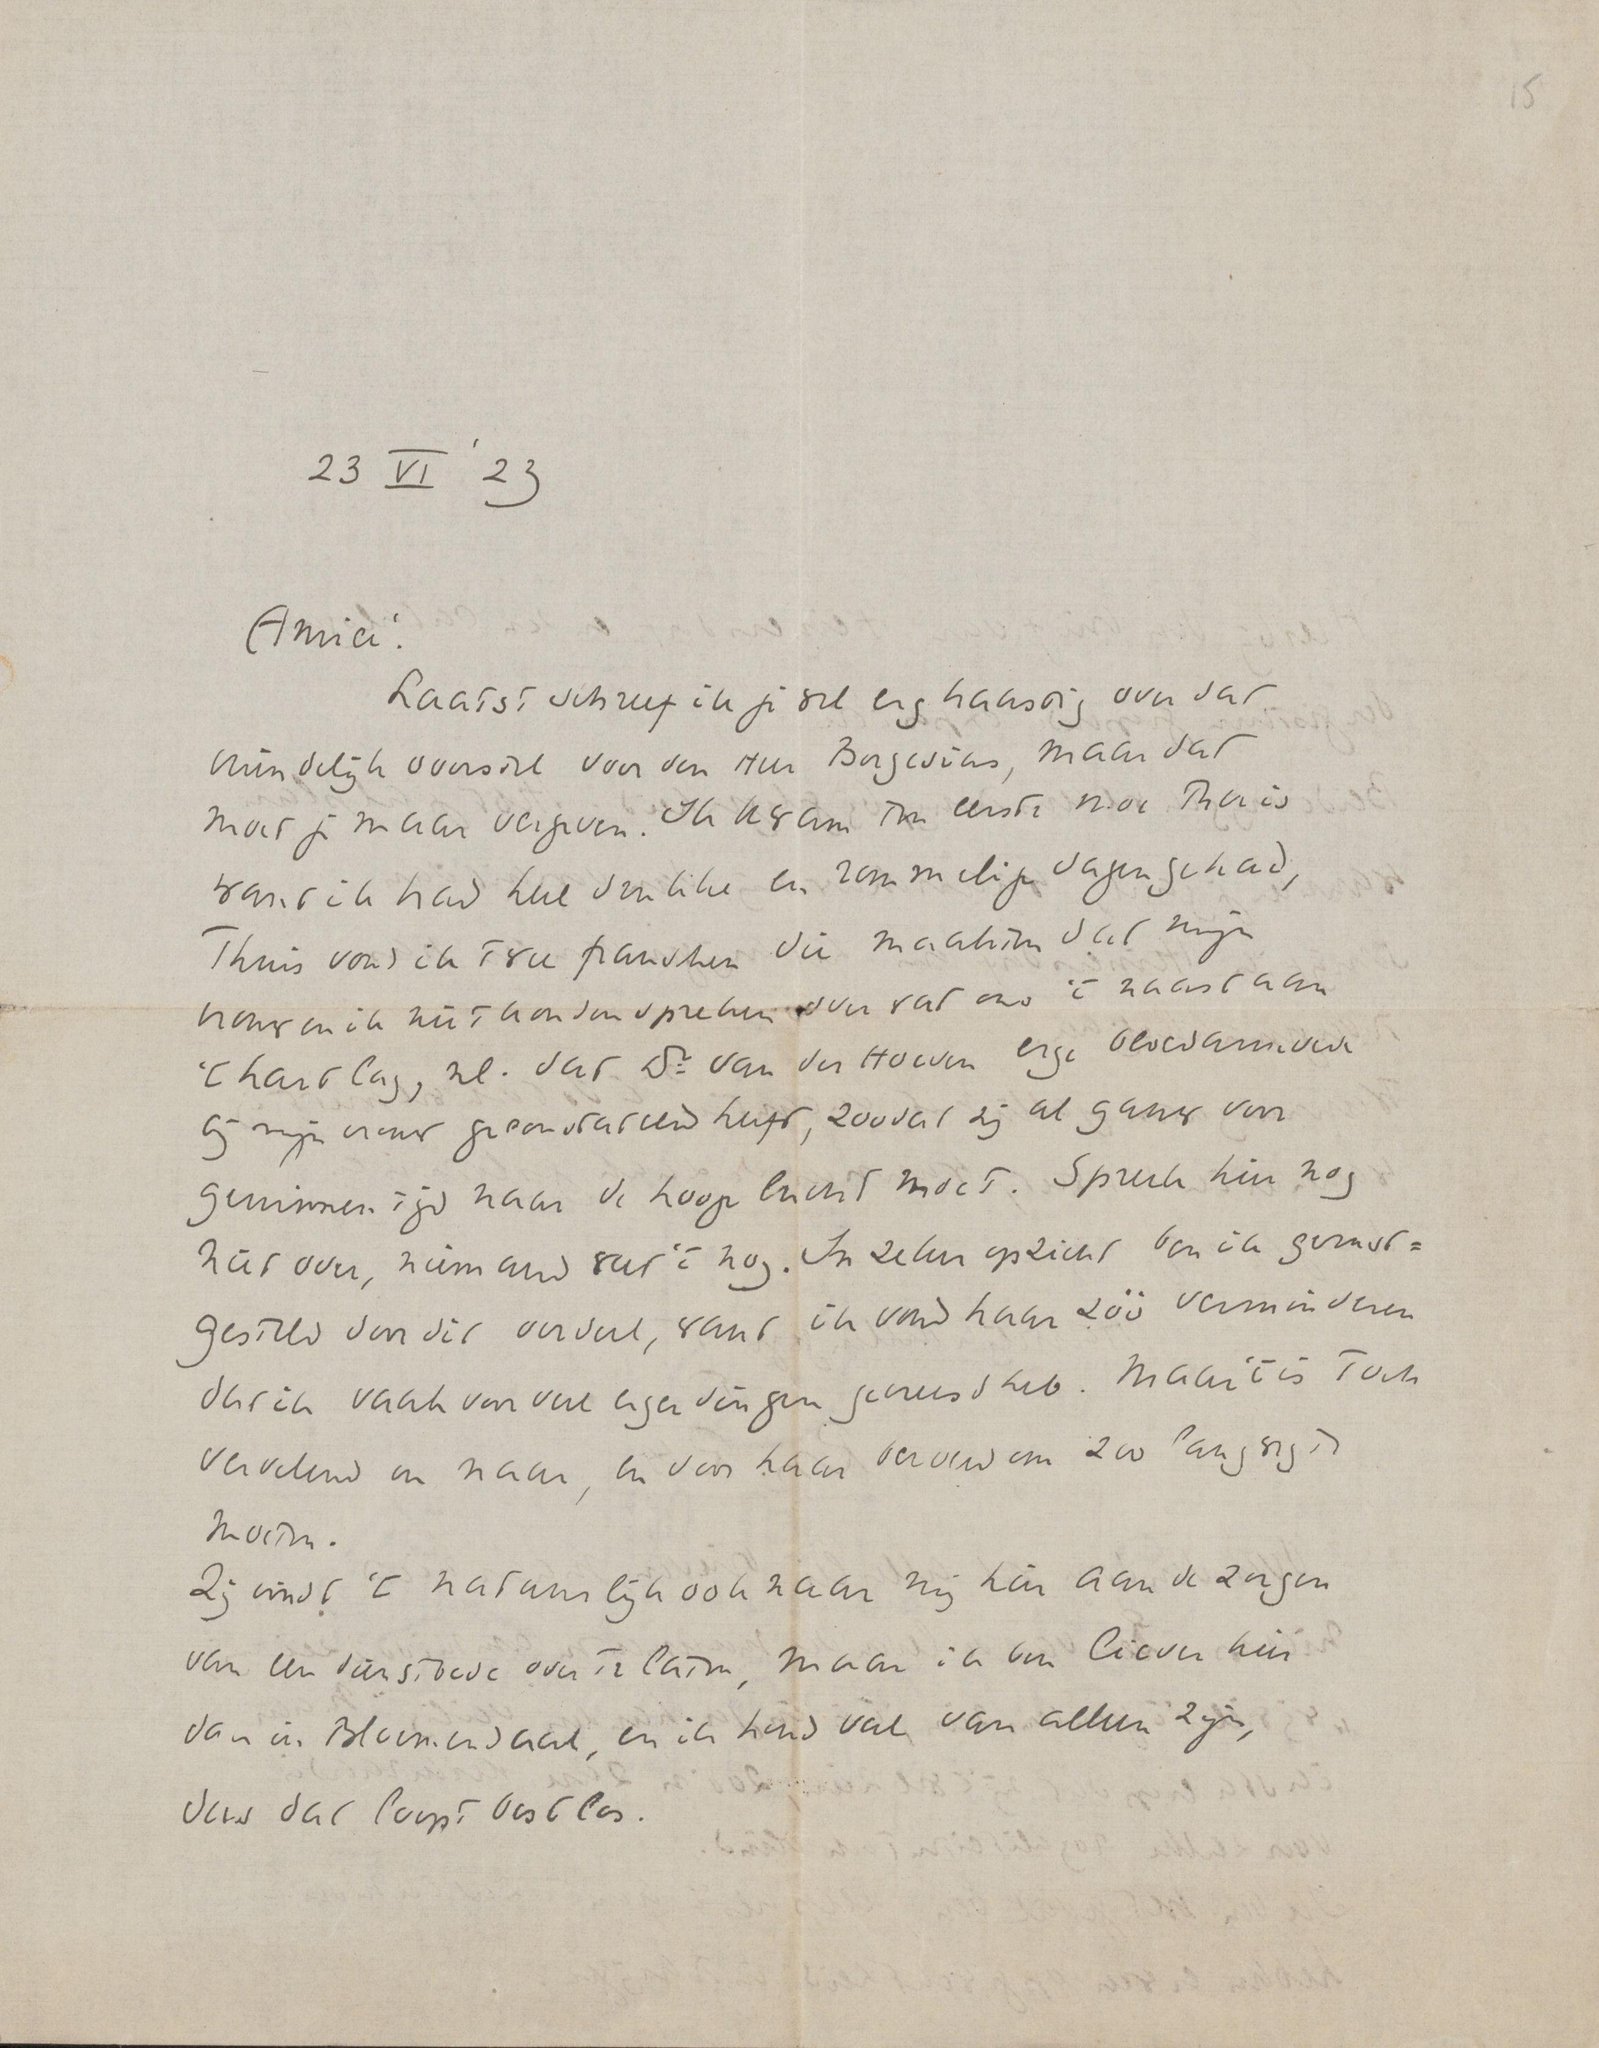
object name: letter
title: Brief aan Willem Bogtman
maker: richard nicolaüs roland holst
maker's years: 1868-1938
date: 1923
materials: ink, paper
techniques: pen, writing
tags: haarlem, willem bogtman, amsterdam, henriëtte roland holst-van der schalk, applied arts, arts and crafts; industrial design, exhibition ~ art, diseases